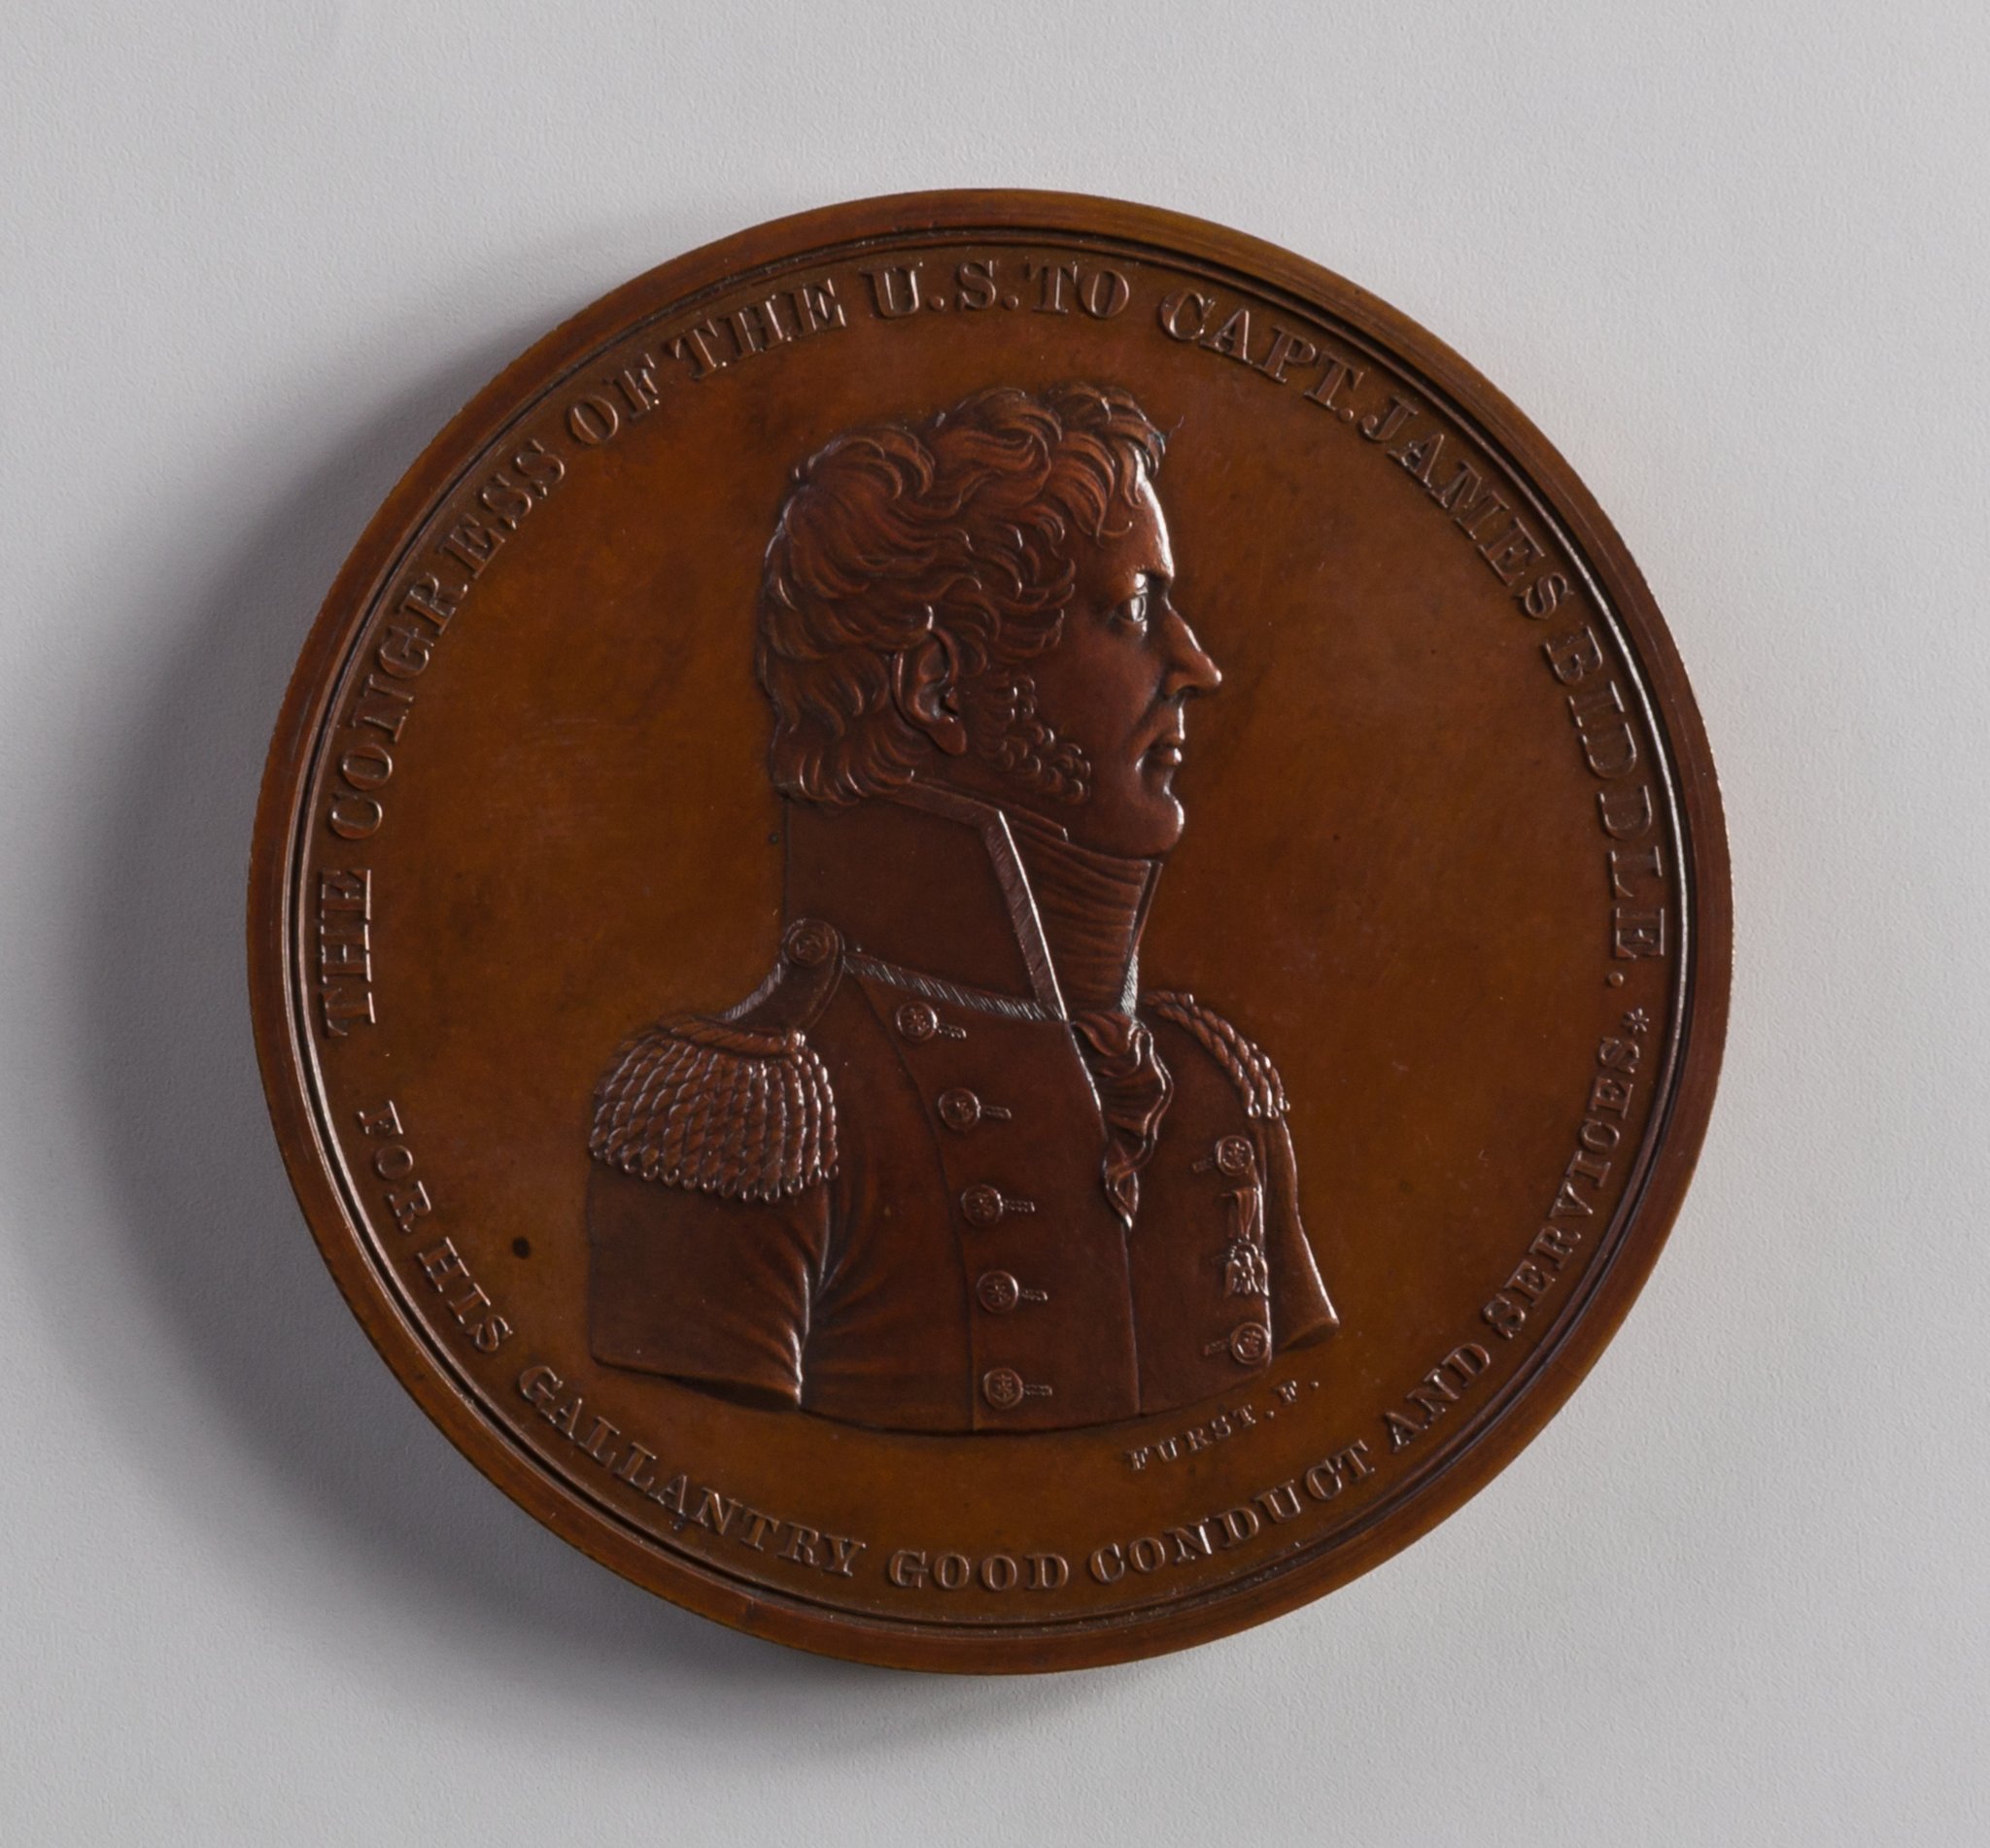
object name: medal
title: Medal of Captain James Biddle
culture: american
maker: moritz fürst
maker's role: maker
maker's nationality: hungarian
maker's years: 1782-1882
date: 1815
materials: bronze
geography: united states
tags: men,portraits,profiles